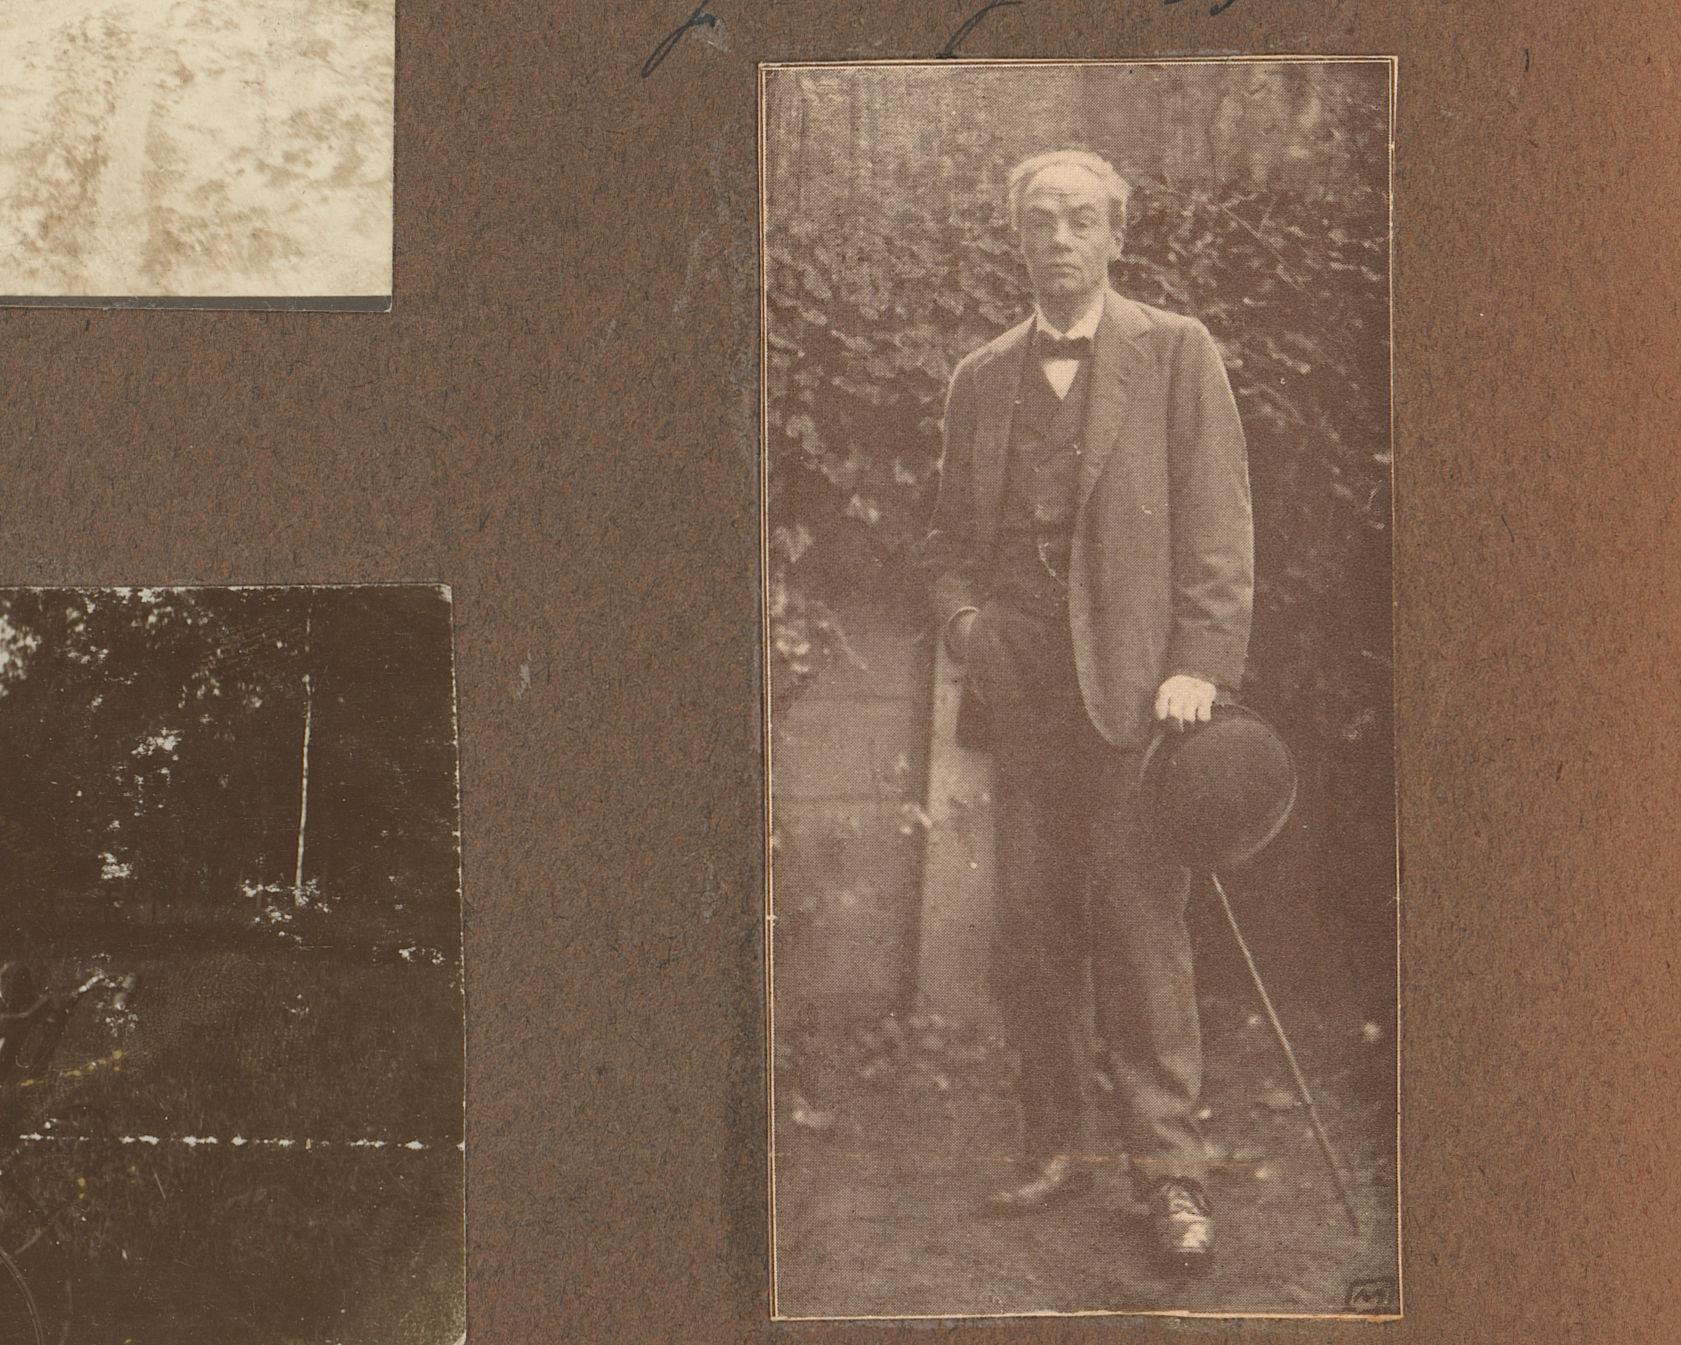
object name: photograph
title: Alphons Diepenbrock staand met hoed en wandelstok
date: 1912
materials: photographic support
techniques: gelatin silver print, pasting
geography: netherlands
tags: amsterdam, alphons diepenbrock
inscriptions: date: ‘1912.’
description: Foto op bruin albumblad 11 van familiealbum van Alphons Diepenbrock.